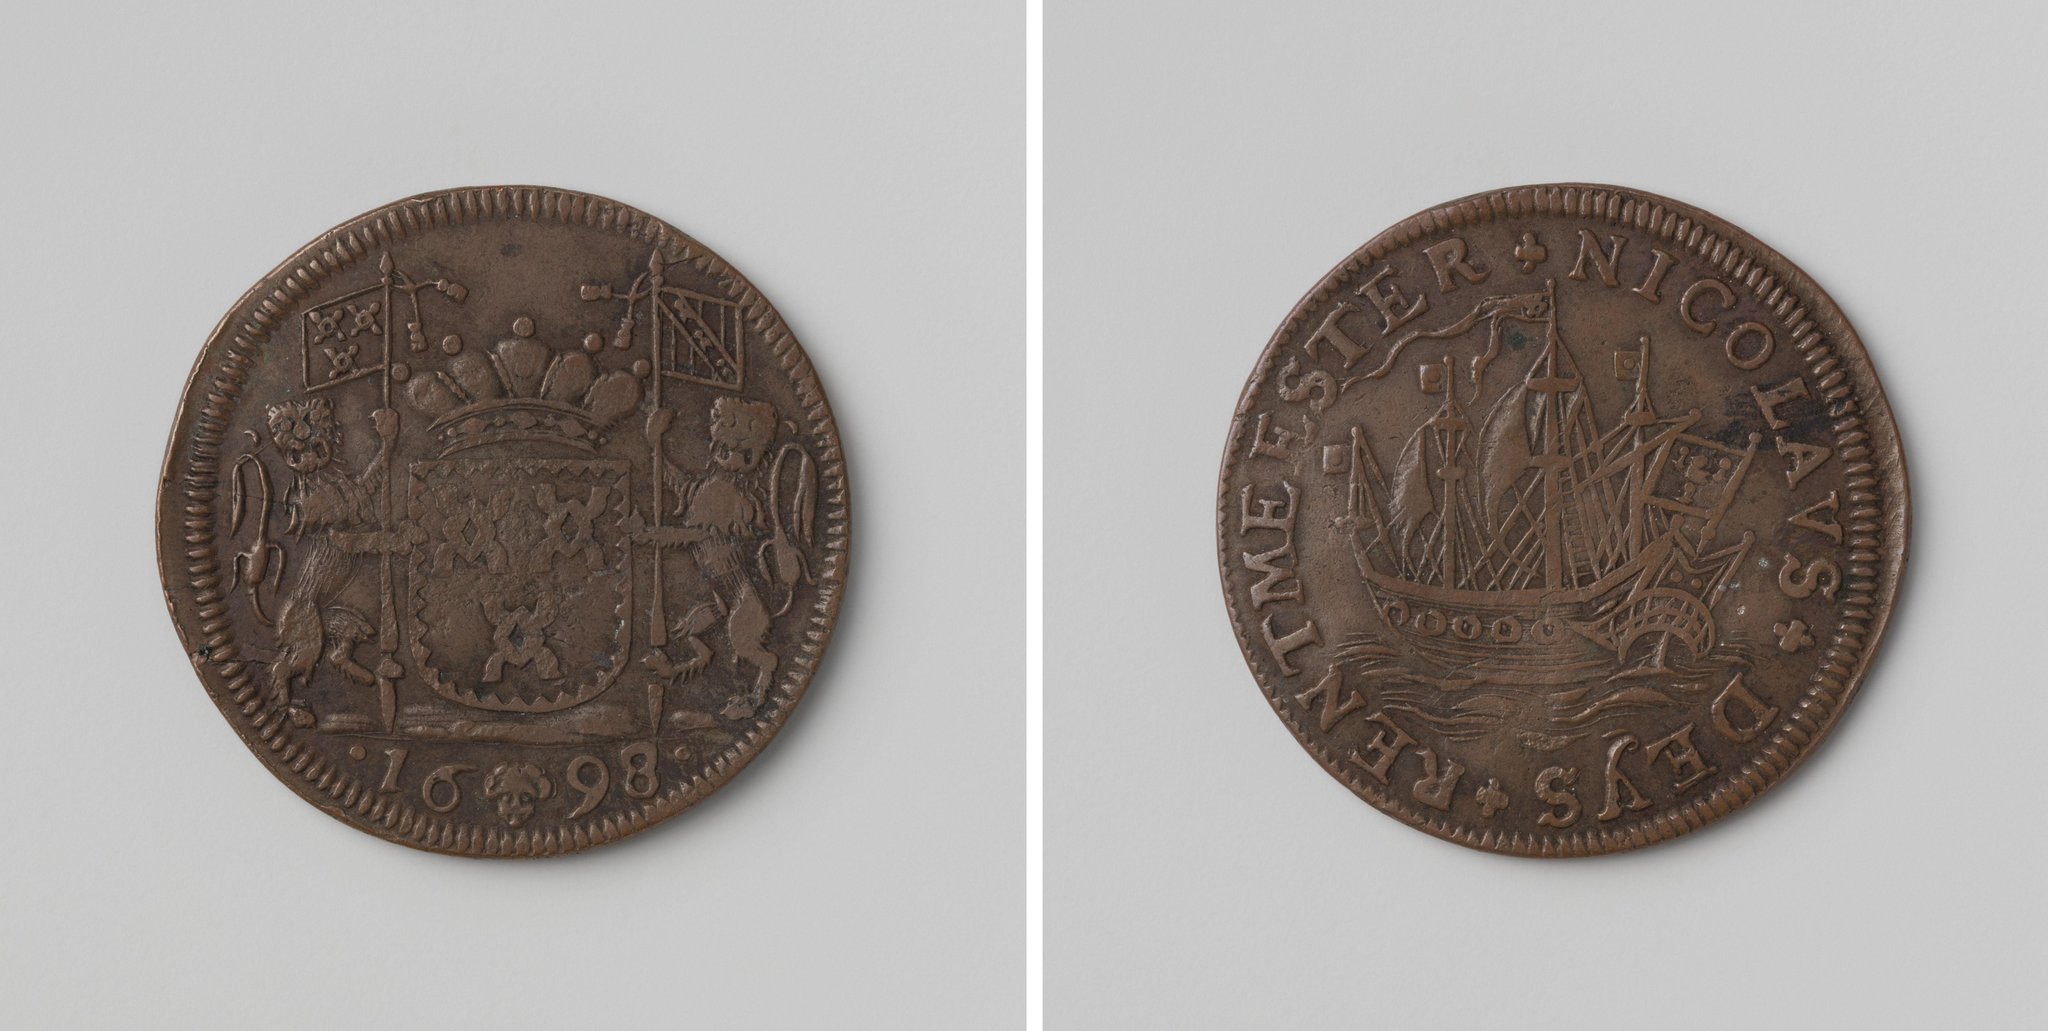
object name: jeton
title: Jean Jacques de Brouckhoven, negenenvijftigste intendant van de Brusselse vaart en Nicolaus Deys, rentmeester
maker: Anonymous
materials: copper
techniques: striking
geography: brussels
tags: intendant, jean jacques de brouckhoven (baron van putte), rentmeester, nicolaus deys, willebroekse vaart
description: Koperen penning. Voorzijde: gekroond wapenschild, geflankeerd door twee leeuwen met banier boven jaartal. Keerzijde: schip op water binnen omschrift